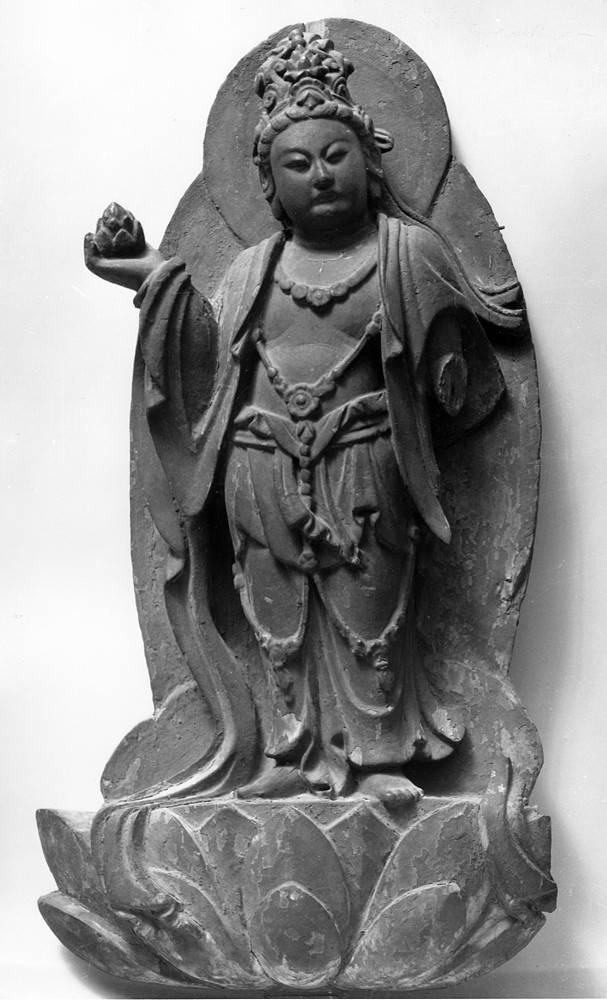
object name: relief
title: Standing Bodhisattva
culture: chinese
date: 1368-1644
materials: wood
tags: buddhism,bodhisattvas